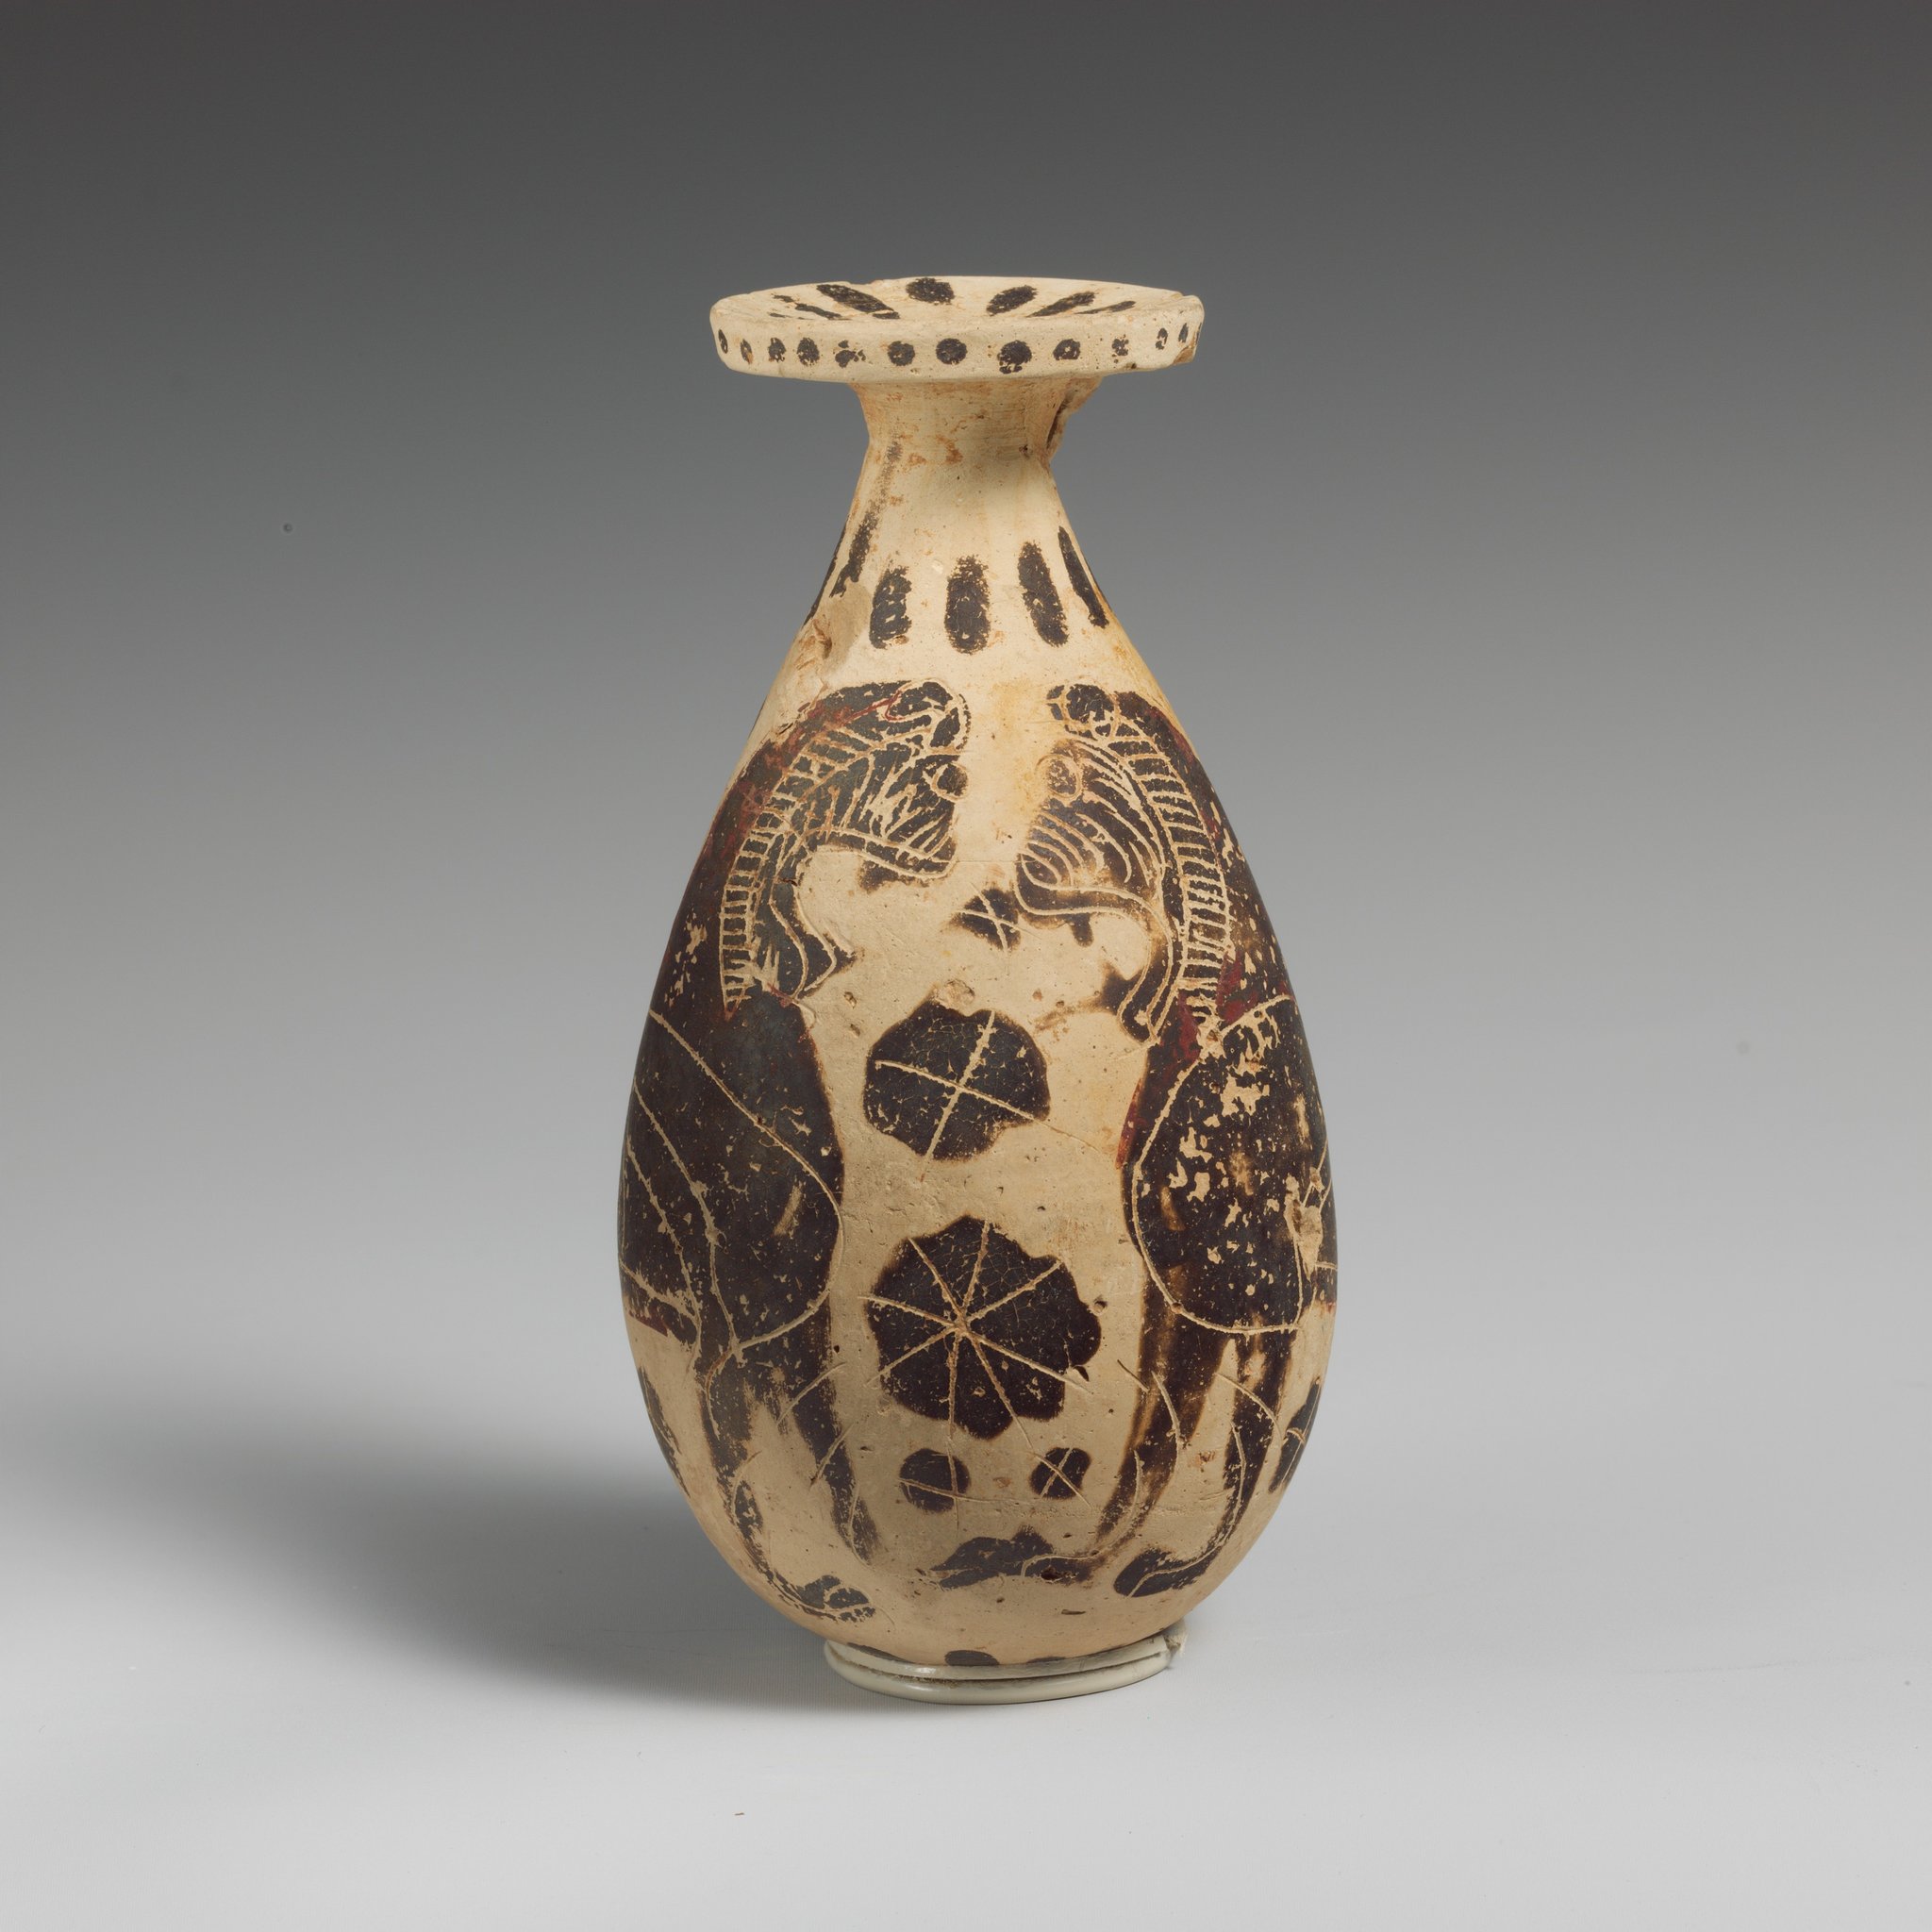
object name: alabastron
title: Terracotta alabastron (oil flask)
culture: greek, corinthian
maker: painter of new york 30.115.26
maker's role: artist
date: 620-590 BCE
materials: terracotta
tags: lions